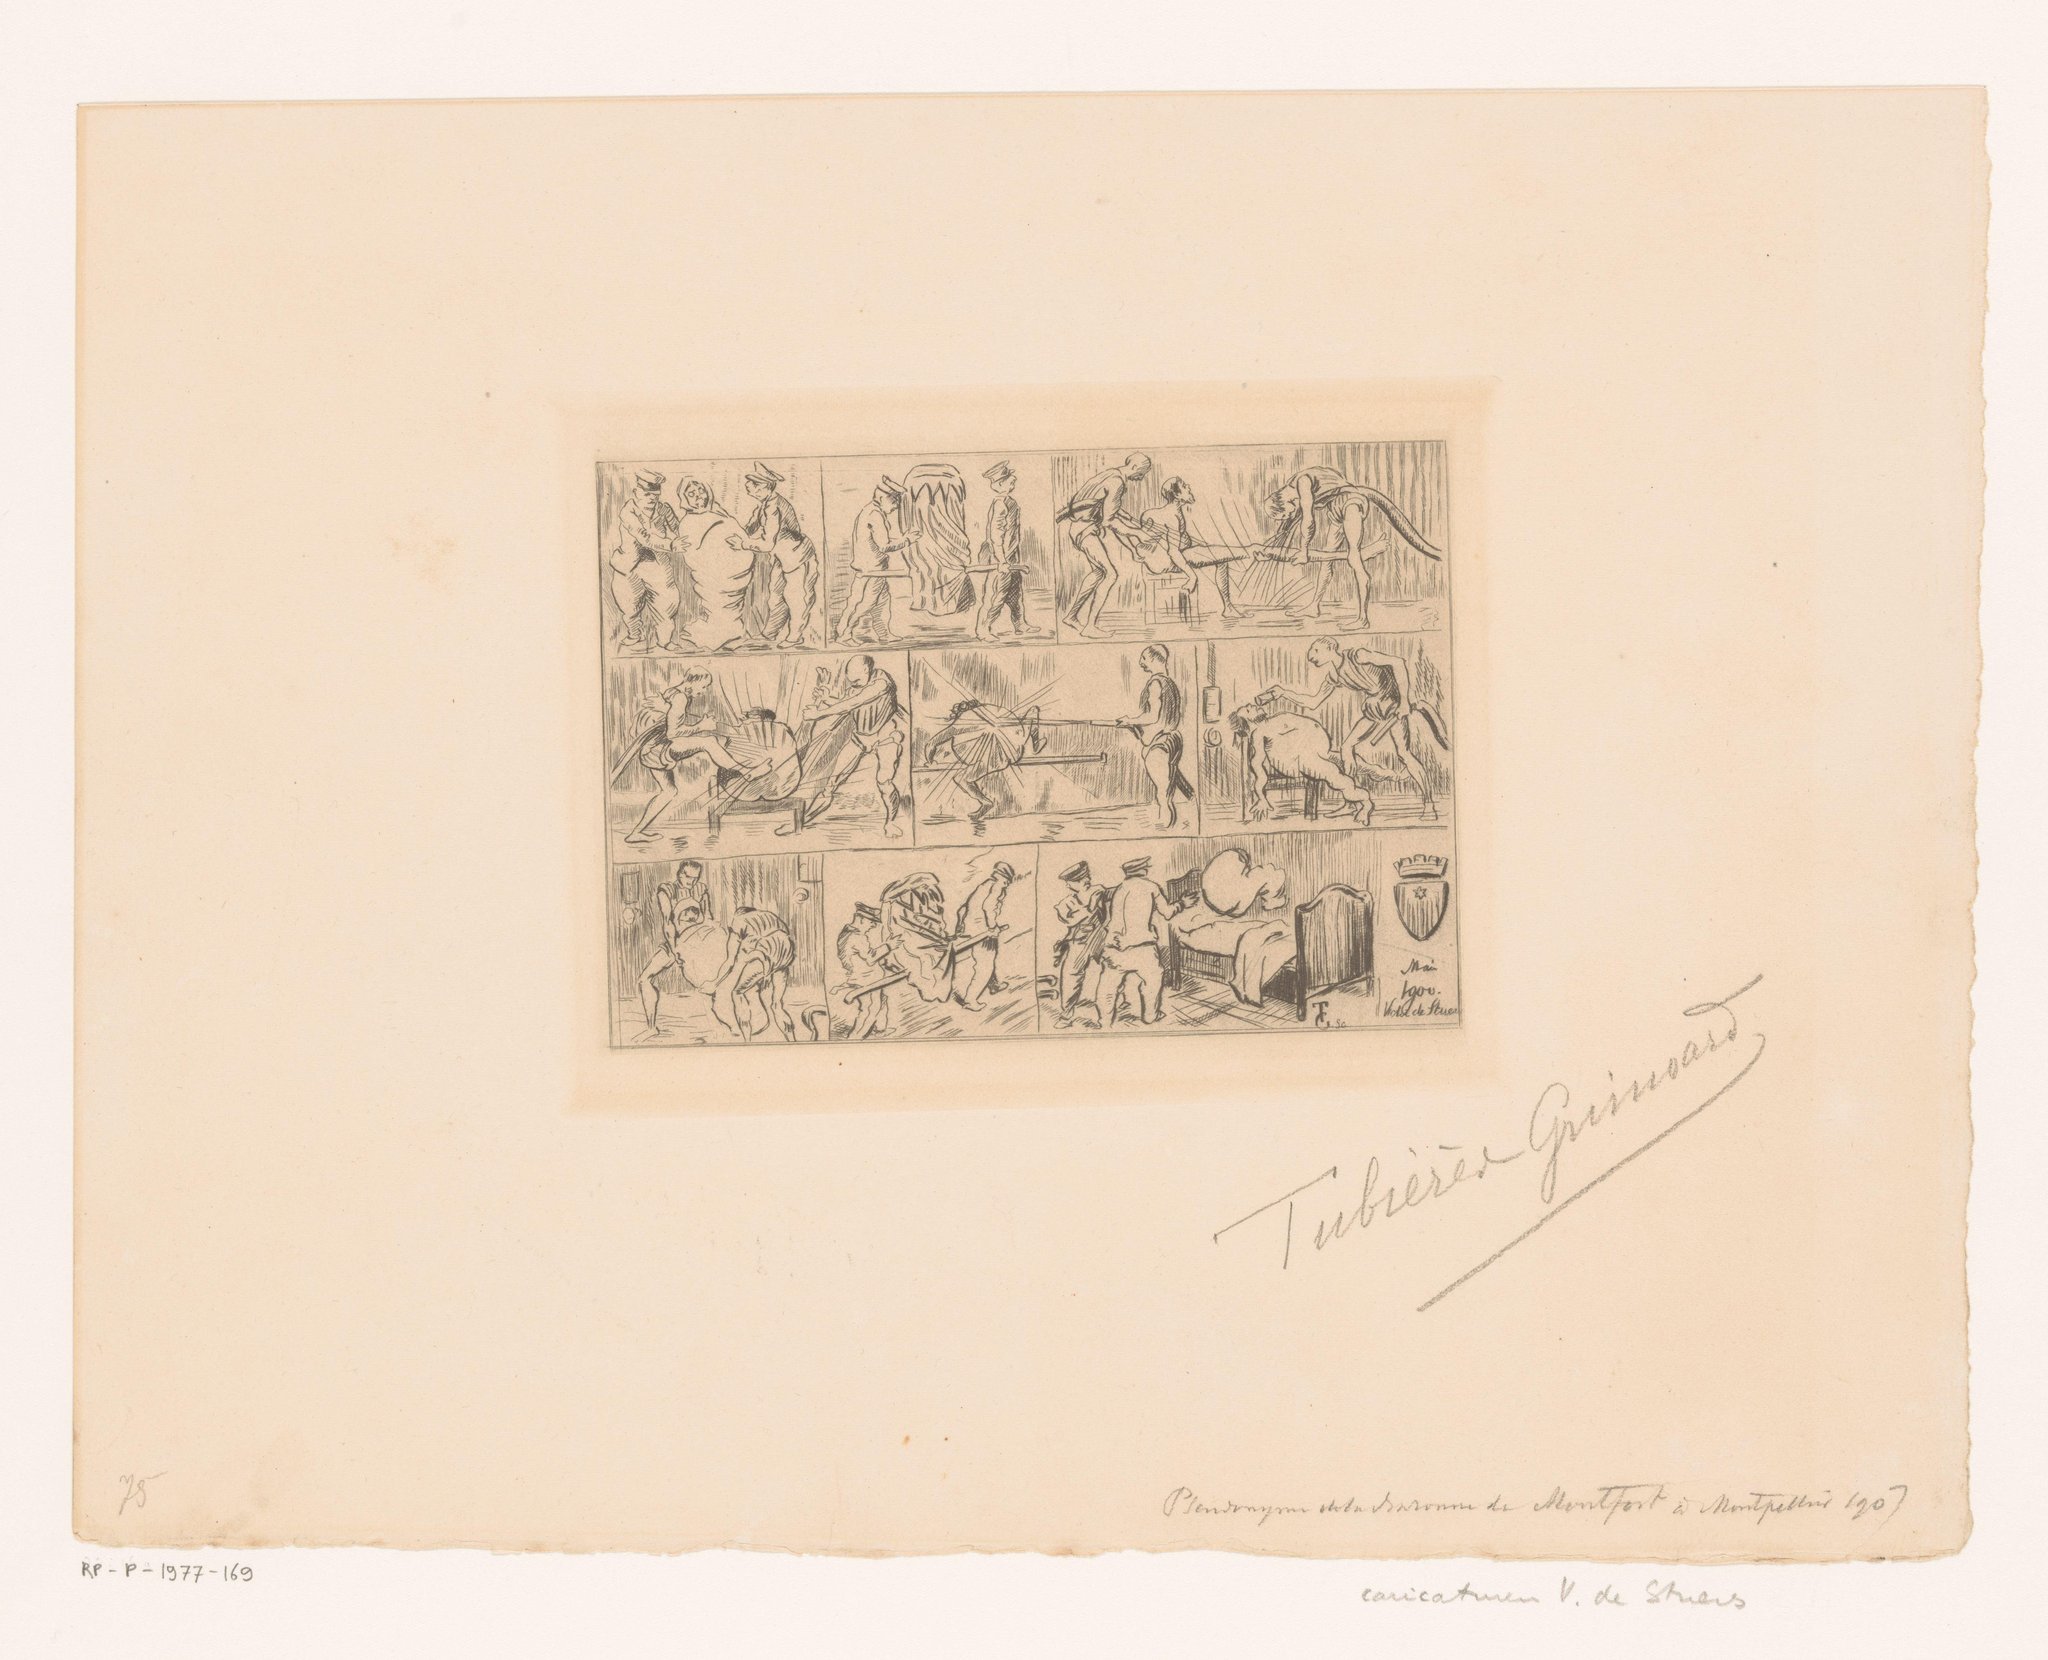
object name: print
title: Karikatuur van de behandeling van een man in een kuuroord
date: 1900-1908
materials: paper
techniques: drypoint, intaglio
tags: massage ~ medical treatment, watering-place, spa, political caricatures and satires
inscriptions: collector's mark: Lugt 2228, inscription: ‘Pseudoniem van de baronnes de Montfort à Montpellier 1907.’, number: ‘75’, inscription: ‘Tubière Grimoard’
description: Volgens een opschrift op andere druk in de collectie (zie RP-P-1908-19), betreft dit een karikatuur van een man behandeld met de 'douche-massage' in een kuuroord te Aix-les-bains.